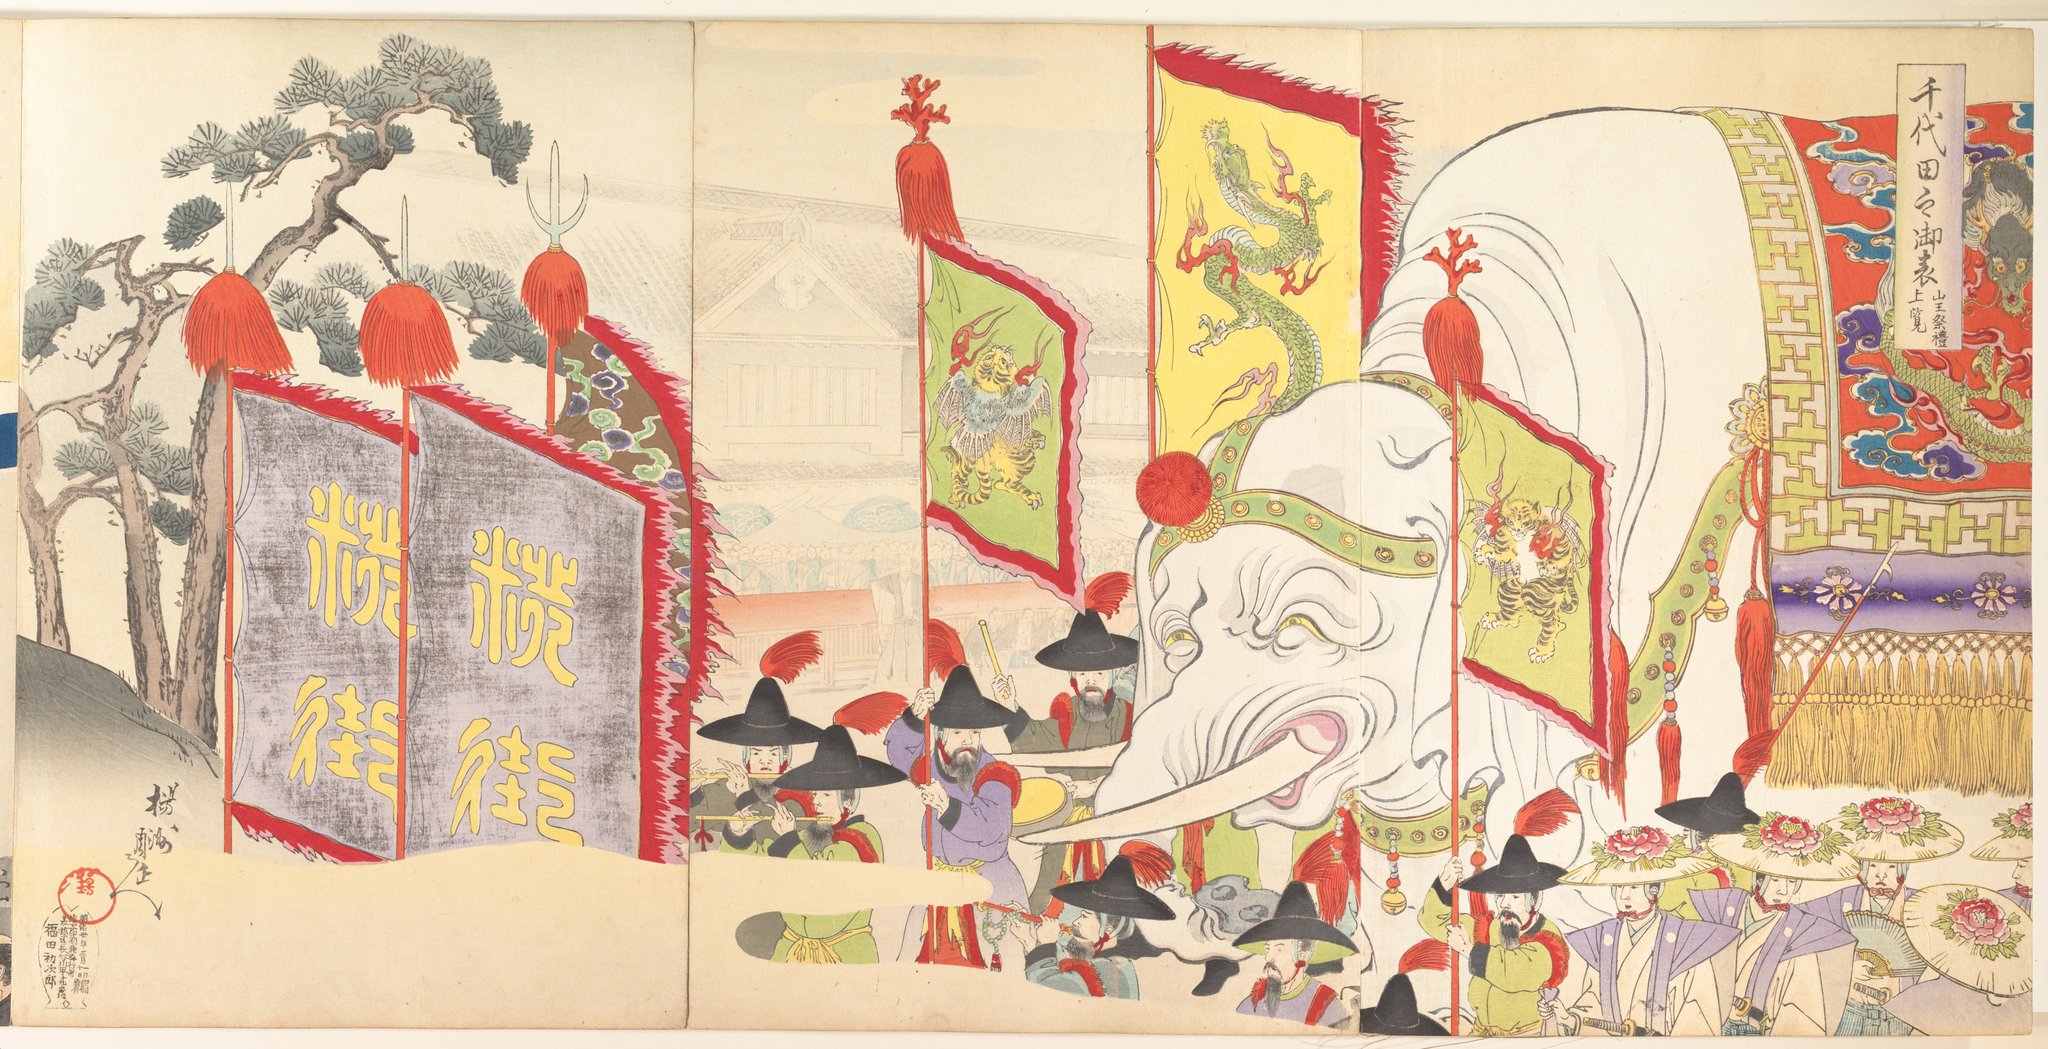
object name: print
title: Chiyoda Castle (Album of Men)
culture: japanese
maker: yōshū (hashimoto) chikanobu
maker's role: artist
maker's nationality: japanese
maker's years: 1838-1912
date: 1897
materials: ink, paper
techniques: woodblock print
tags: men,elephants,trees,flags